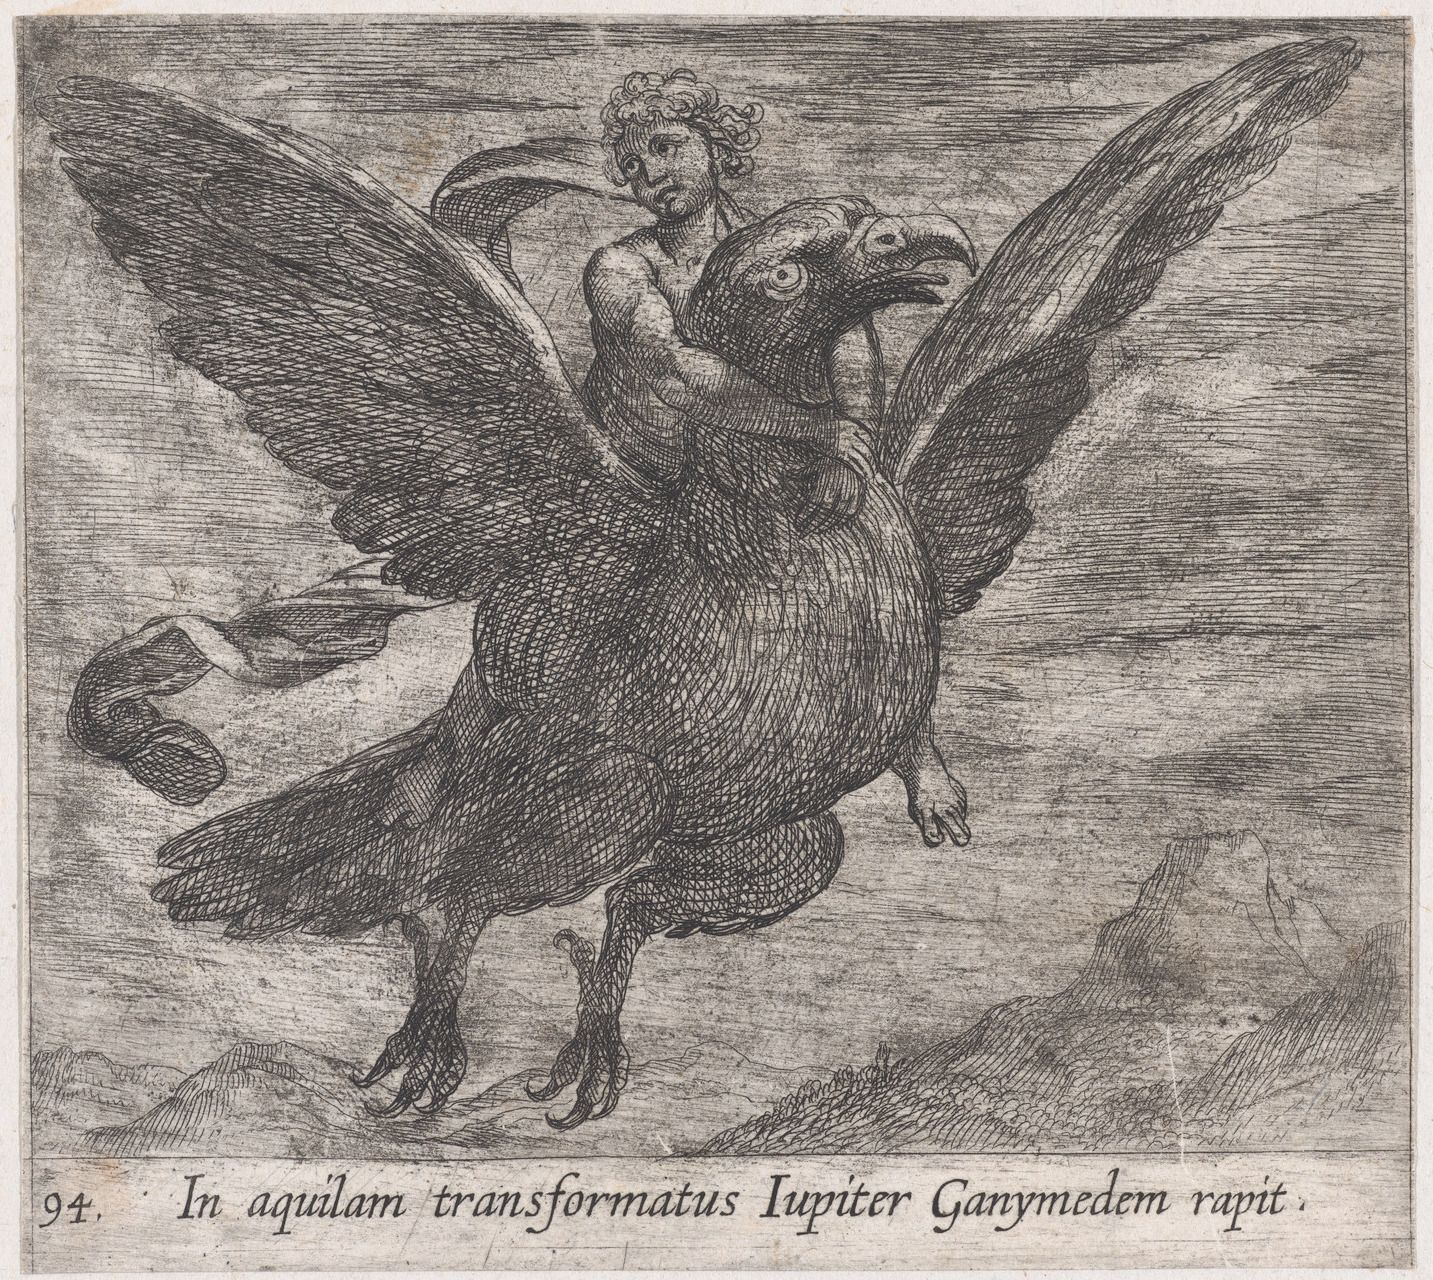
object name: print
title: Plate 94: Jupiter and Ganymede (In aquilam transformatus Iupiter Ganymedem rapit), from Ovid's 'Metamorphoses'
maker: antonio tempesta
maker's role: artist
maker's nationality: italian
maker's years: 1555-1630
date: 1606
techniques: etching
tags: eagles,jupiter